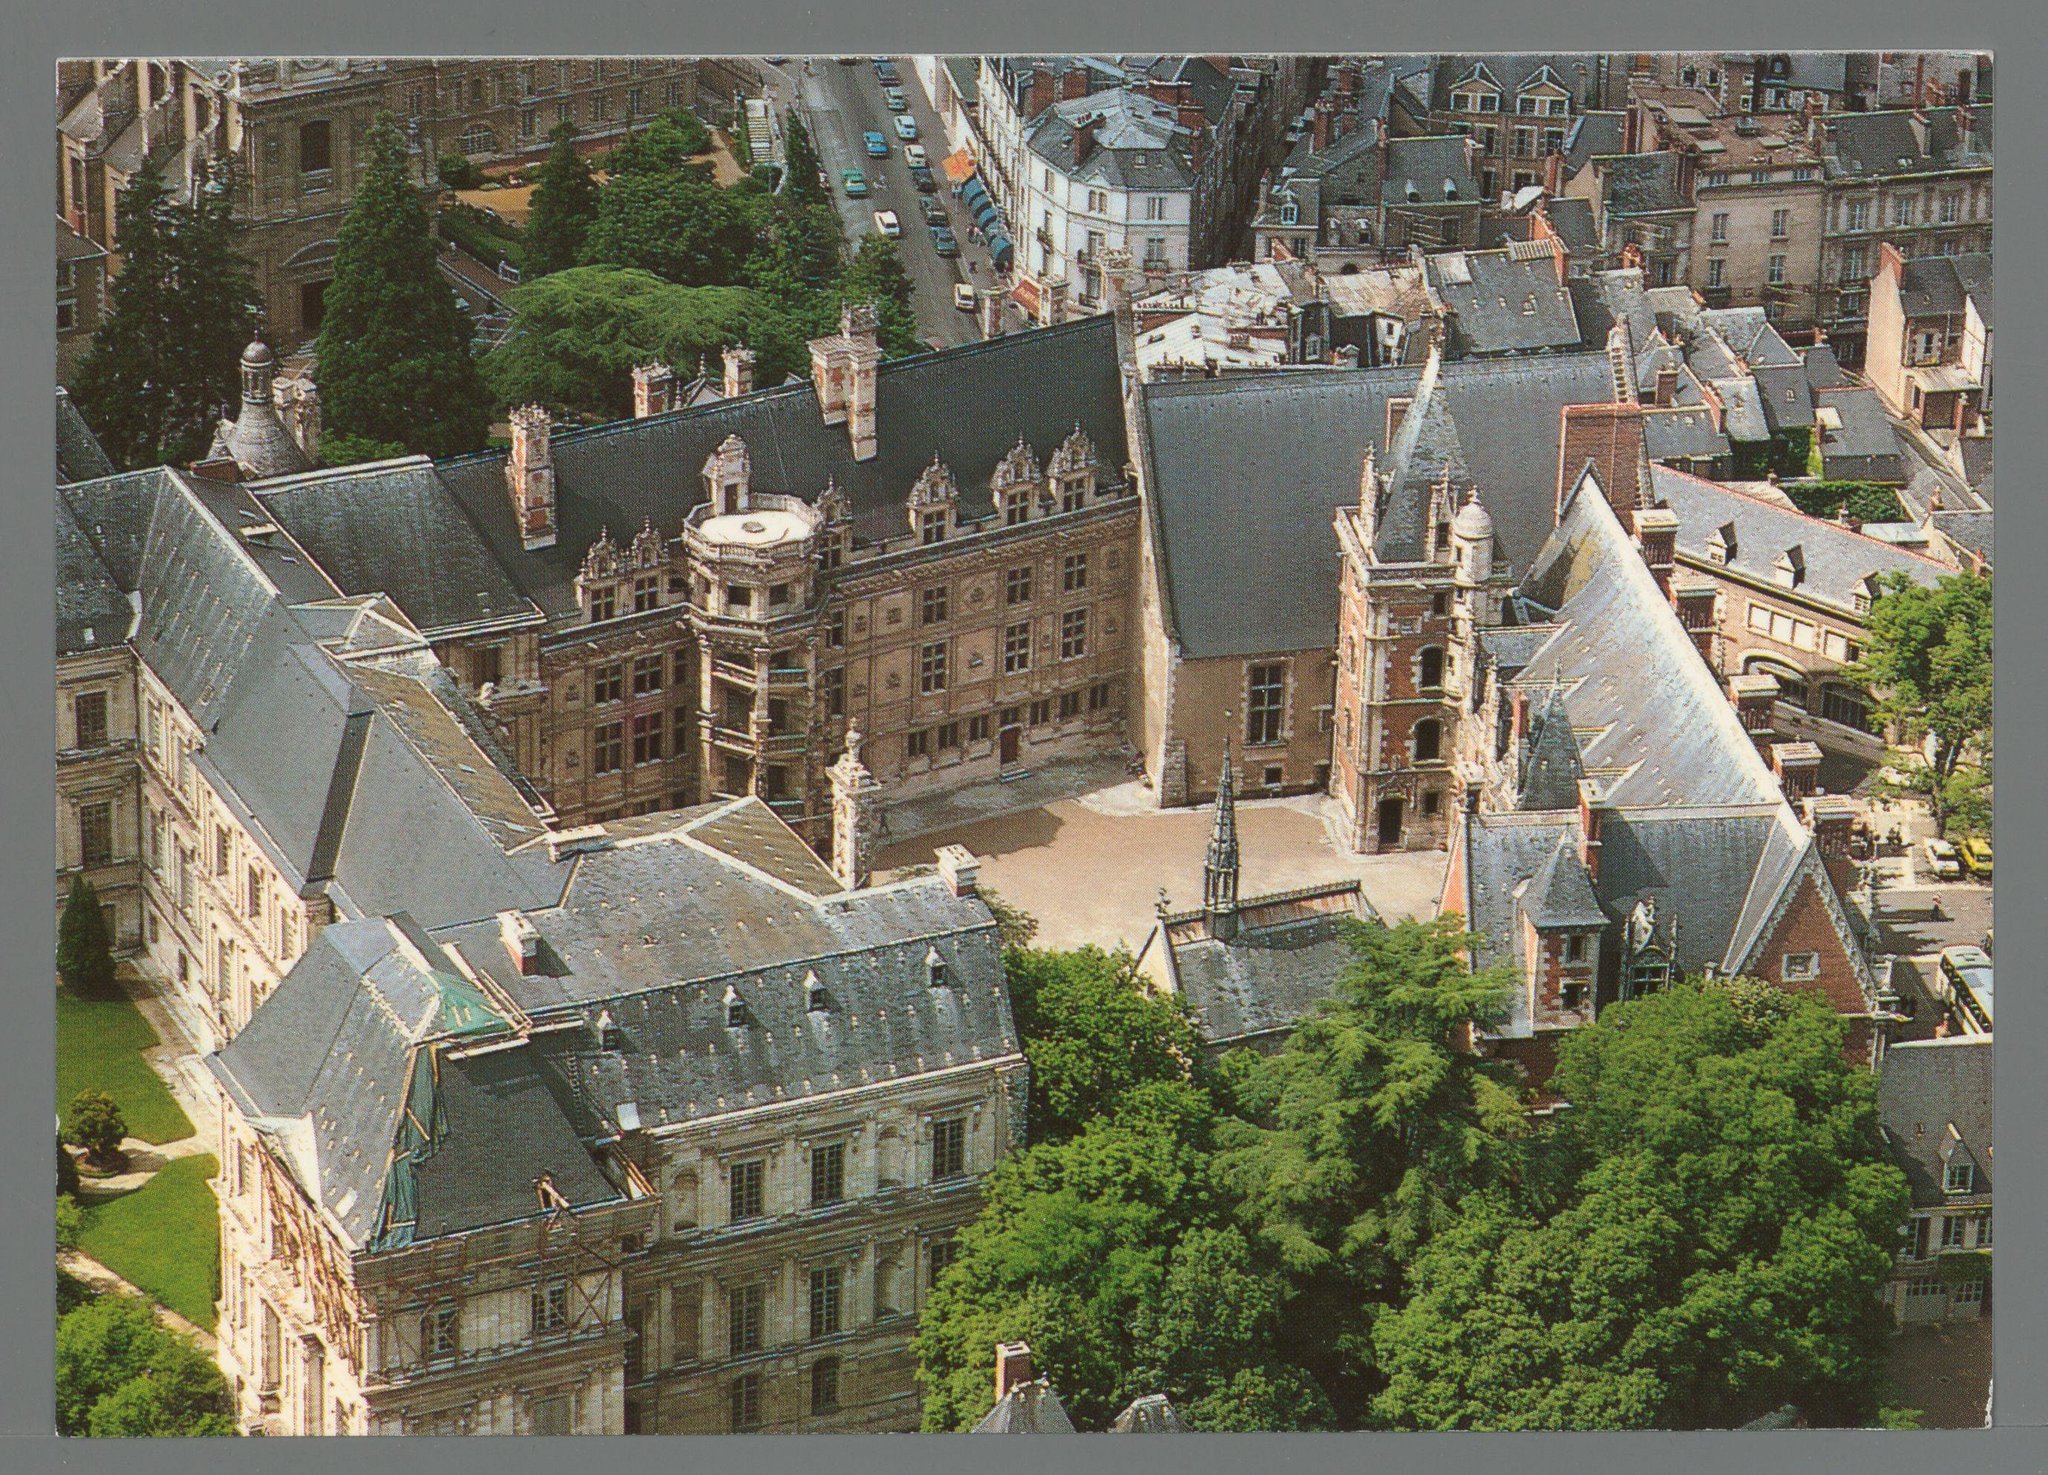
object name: photomechanical print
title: Blois (Loir-et-Cher-41). La façade Gaston d'Orléans et l 'Escalier François Ier / The Gaston d'Orléans façade and the Francis I staircase / Fassade Gaston d'Orléans und Treppe Franz I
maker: Anonymous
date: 1958-1990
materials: cardboard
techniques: offset printed, writing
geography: carquefou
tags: castle, exterior ~ representation of a building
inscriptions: inscription: ‘[...] 1990.’